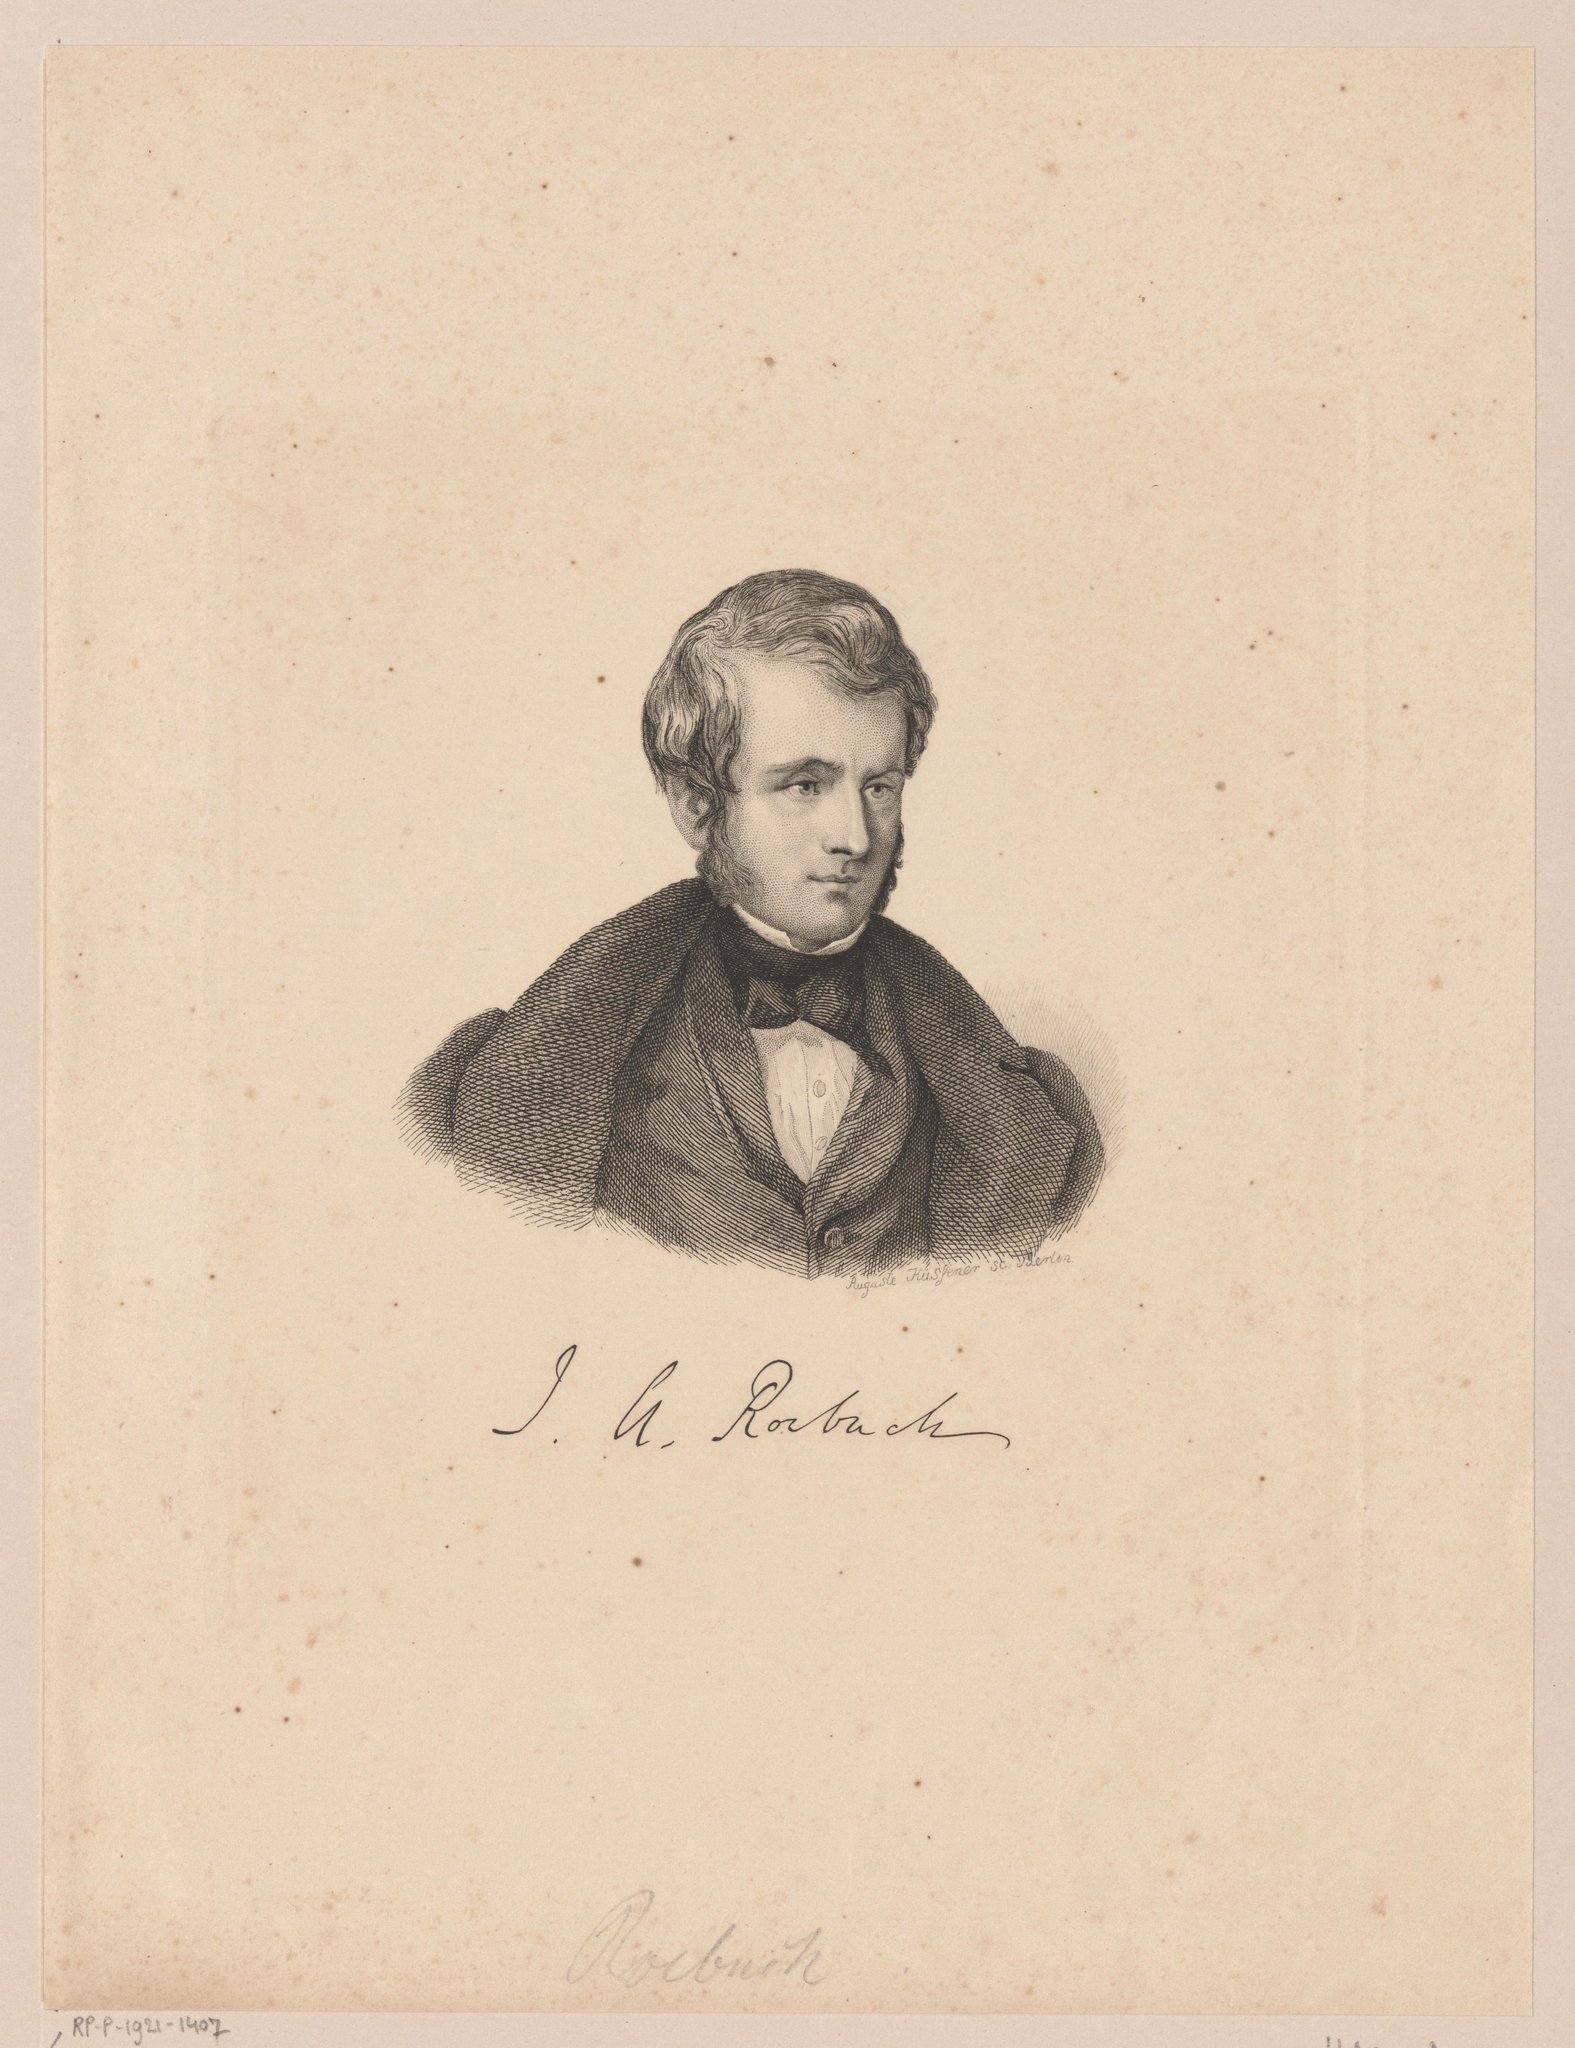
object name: print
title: Portret van John Arthur Roebuck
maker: auguste hüssener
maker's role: print maker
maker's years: 1789-1877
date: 1812-1877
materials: paper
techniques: etching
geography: berlin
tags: politician, historical persons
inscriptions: collector's mark: Lugt 2233